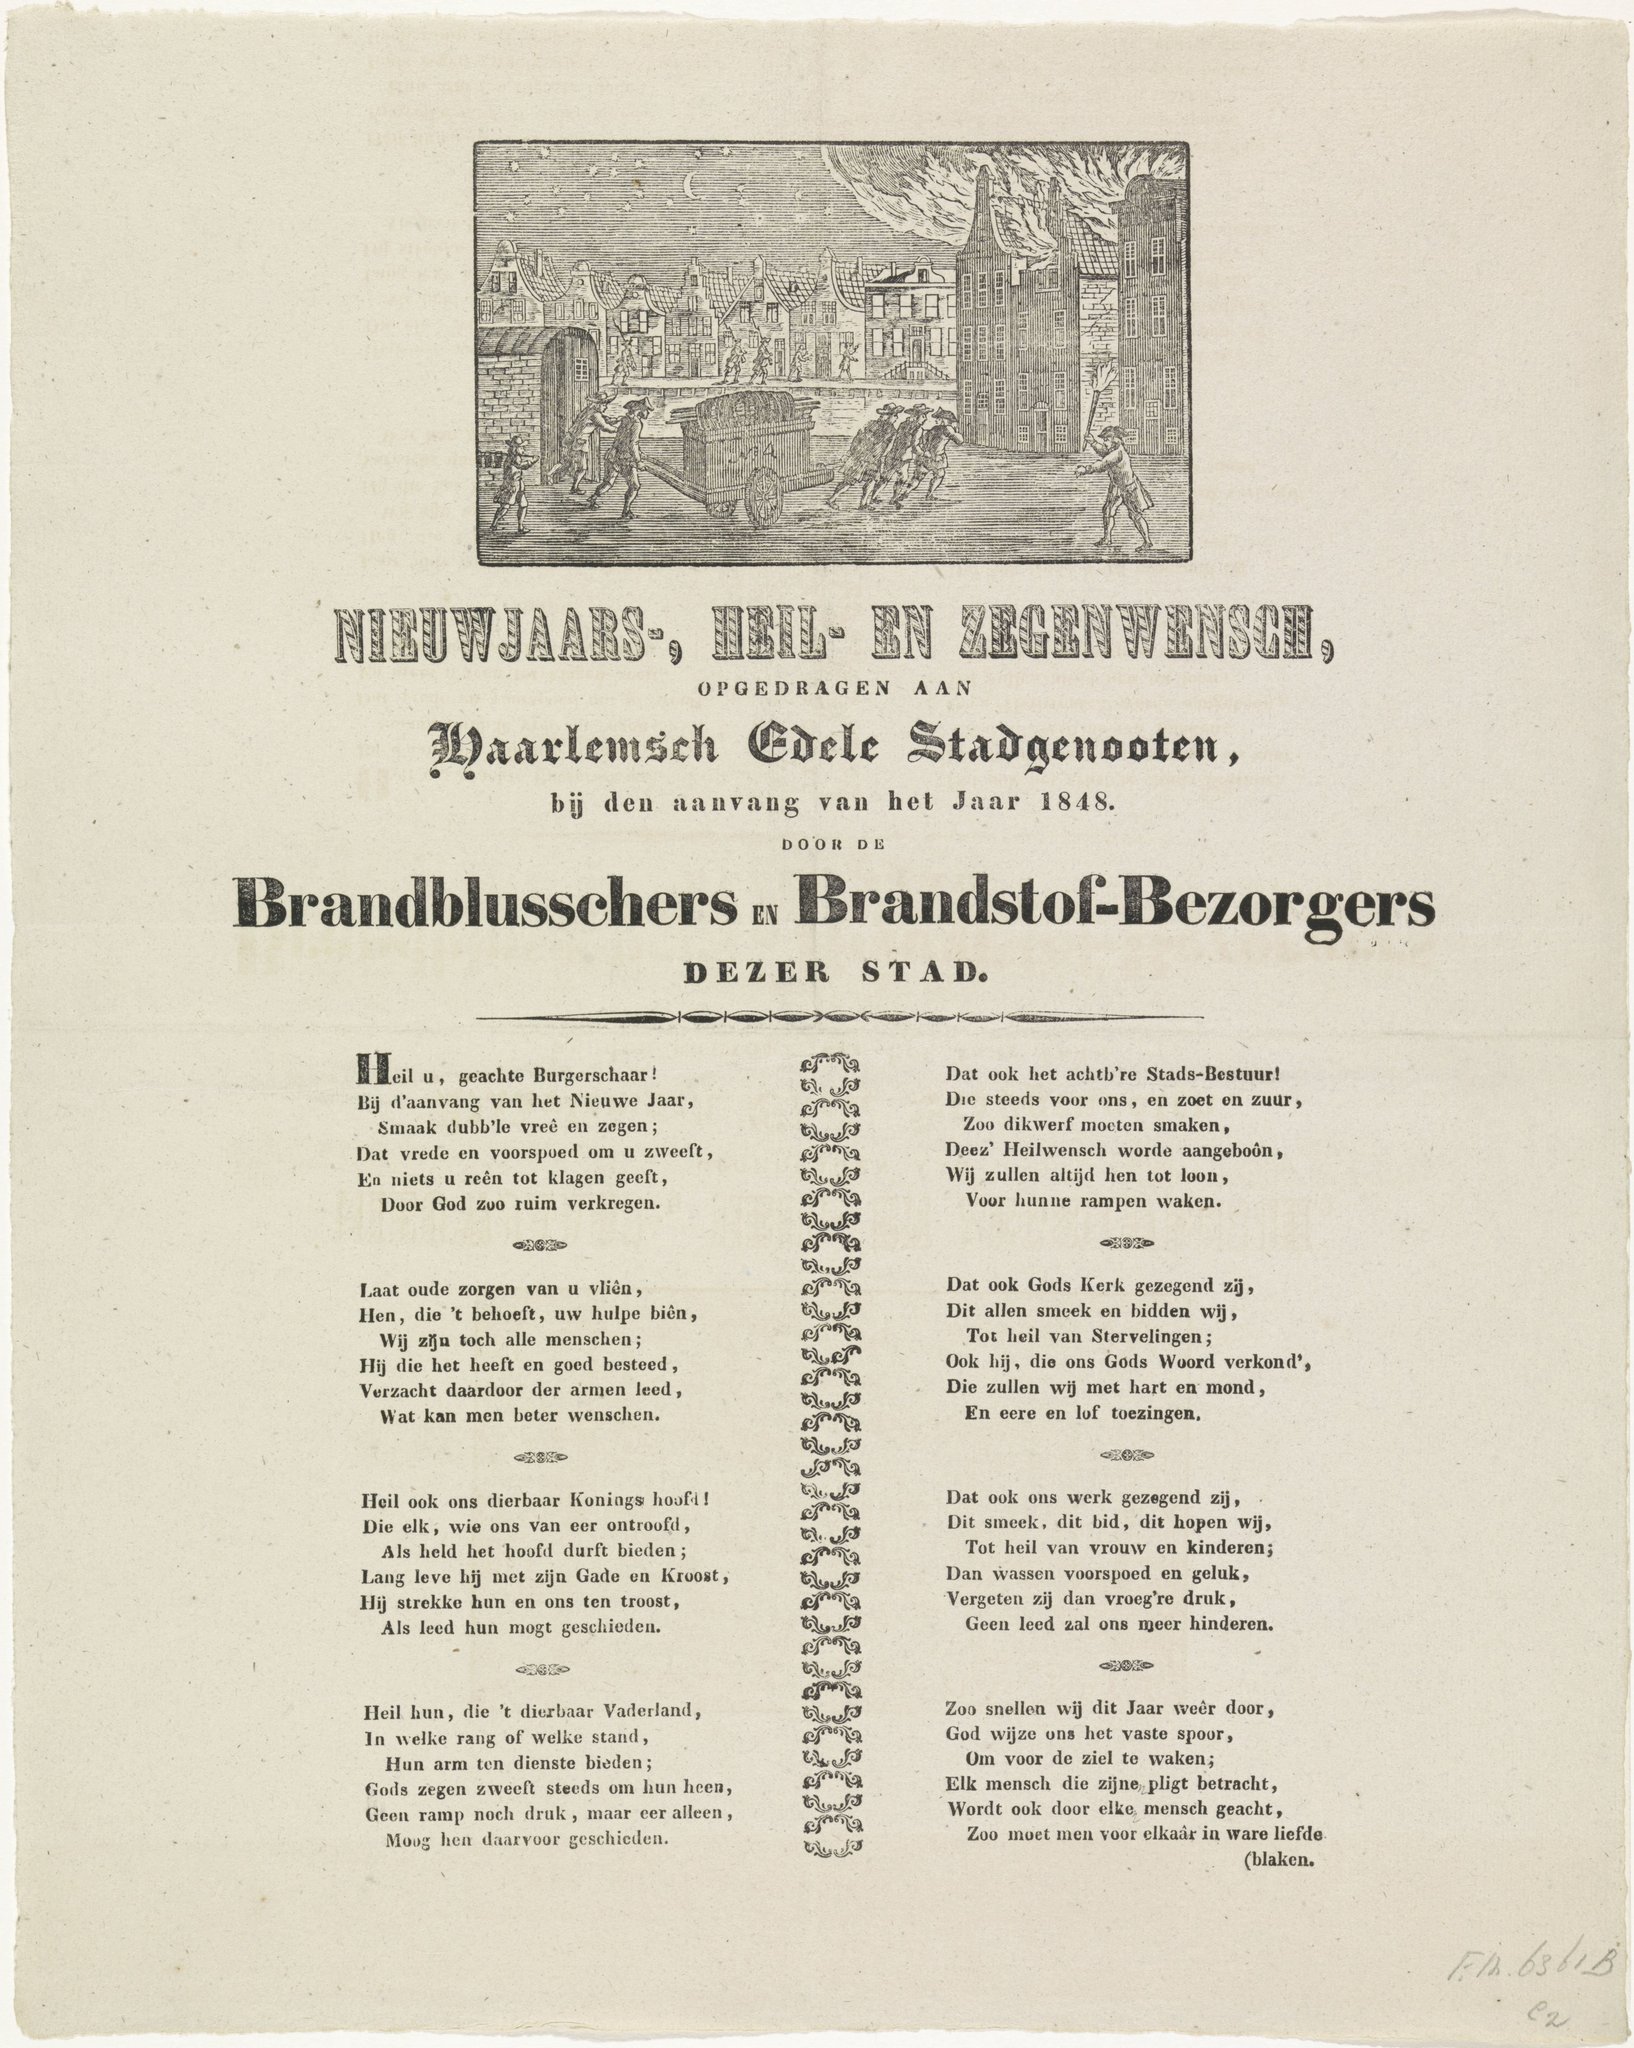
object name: print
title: Nieuwjaarswens van de brandblussers en brandstofbezorgers van Haarlem voor het jaar 1848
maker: Anonymous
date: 1847-1848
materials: paper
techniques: letterpress printing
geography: haarlem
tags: fire-department, fire-brigade, street, haarlem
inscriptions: collector's mark: Lugt 2228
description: Nieuwjaarswens van de Haarlemse brandblussers en brandstofbezorger voor het jaar 1848. De brandweer rukt uit met een brandspuit om een brand in enkele panden aan een gracht te blussen. Met een vers in twee kolommen.